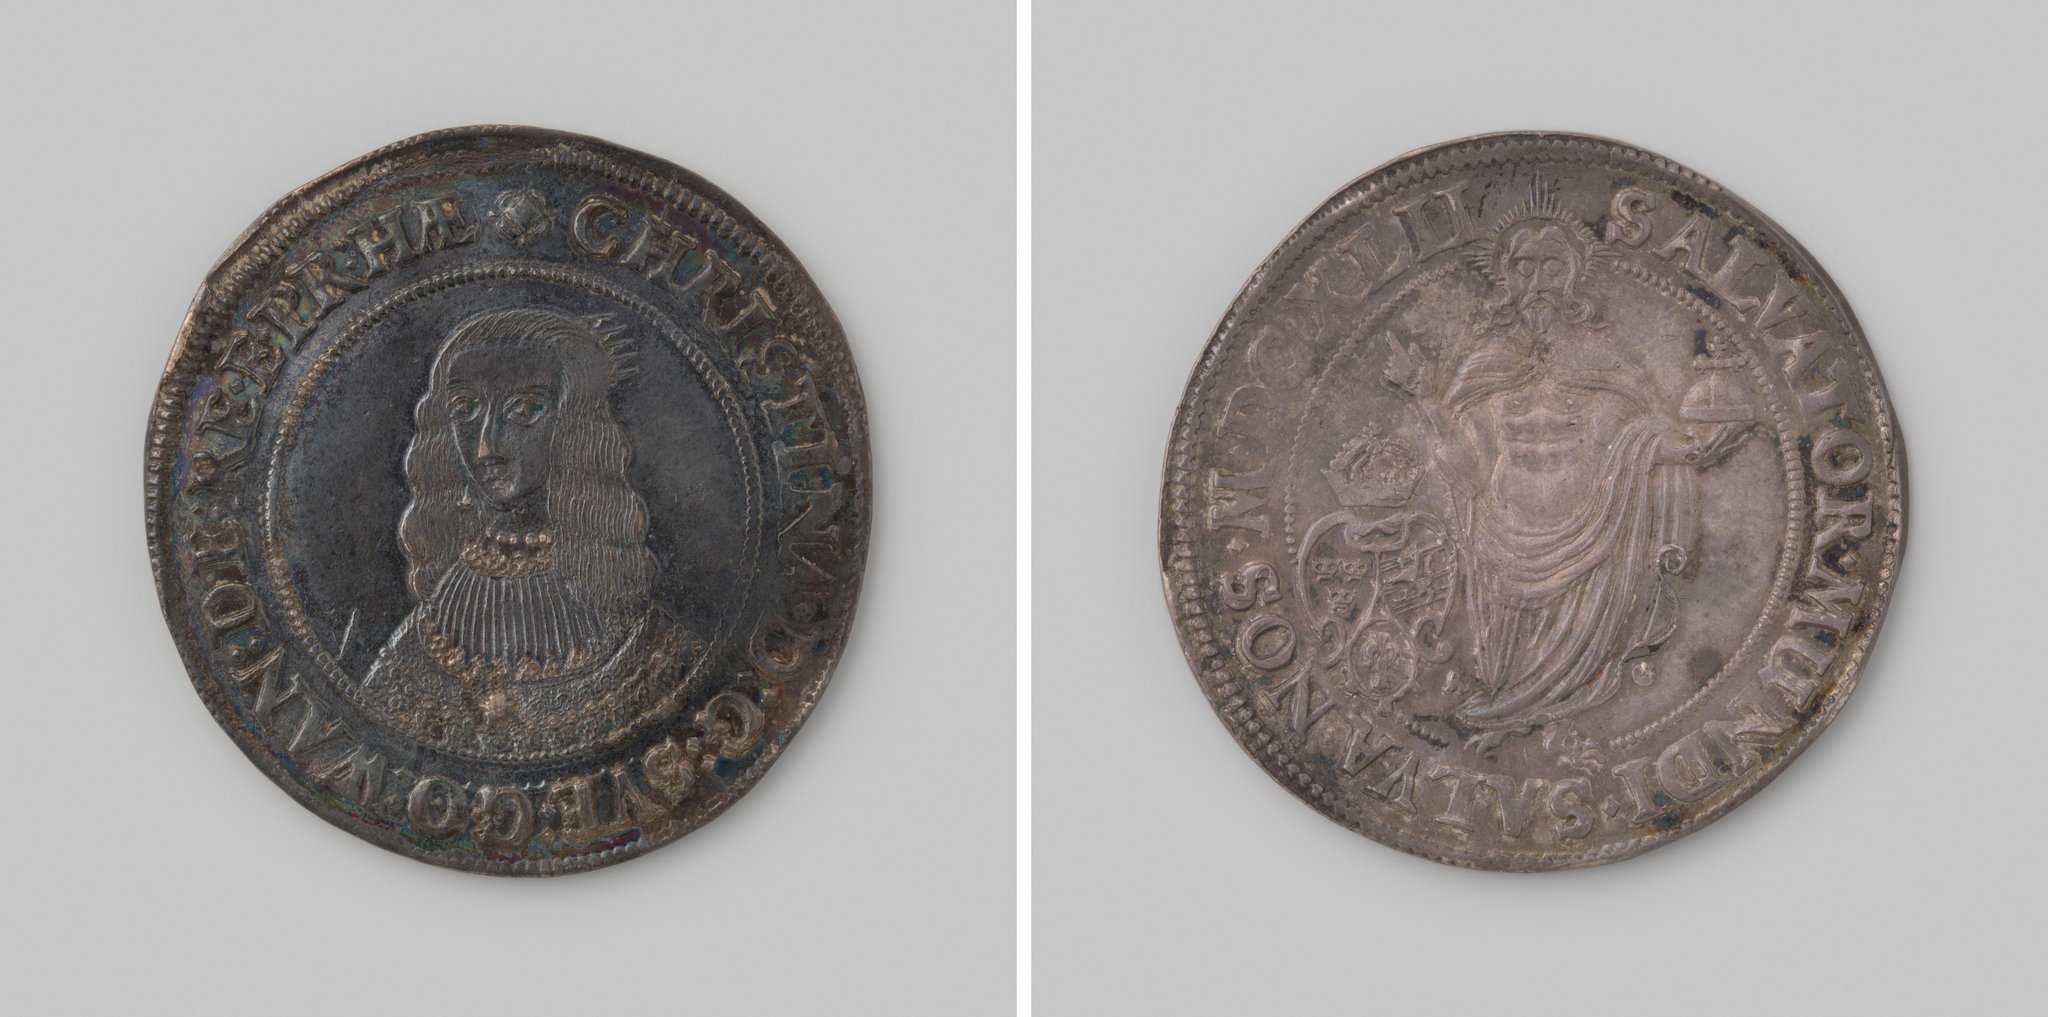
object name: coin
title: Zweden, Kristina, ½ riksdaler,1642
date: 1642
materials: silver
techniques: striking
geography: slot rörstrand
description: Zilveren munt. Voorzijde: portret van de koningin naar links. Keerzijde: de Zaligmaker met links van hem gekroond wapenschild. Jaartal in omschrft. Gladde rand.